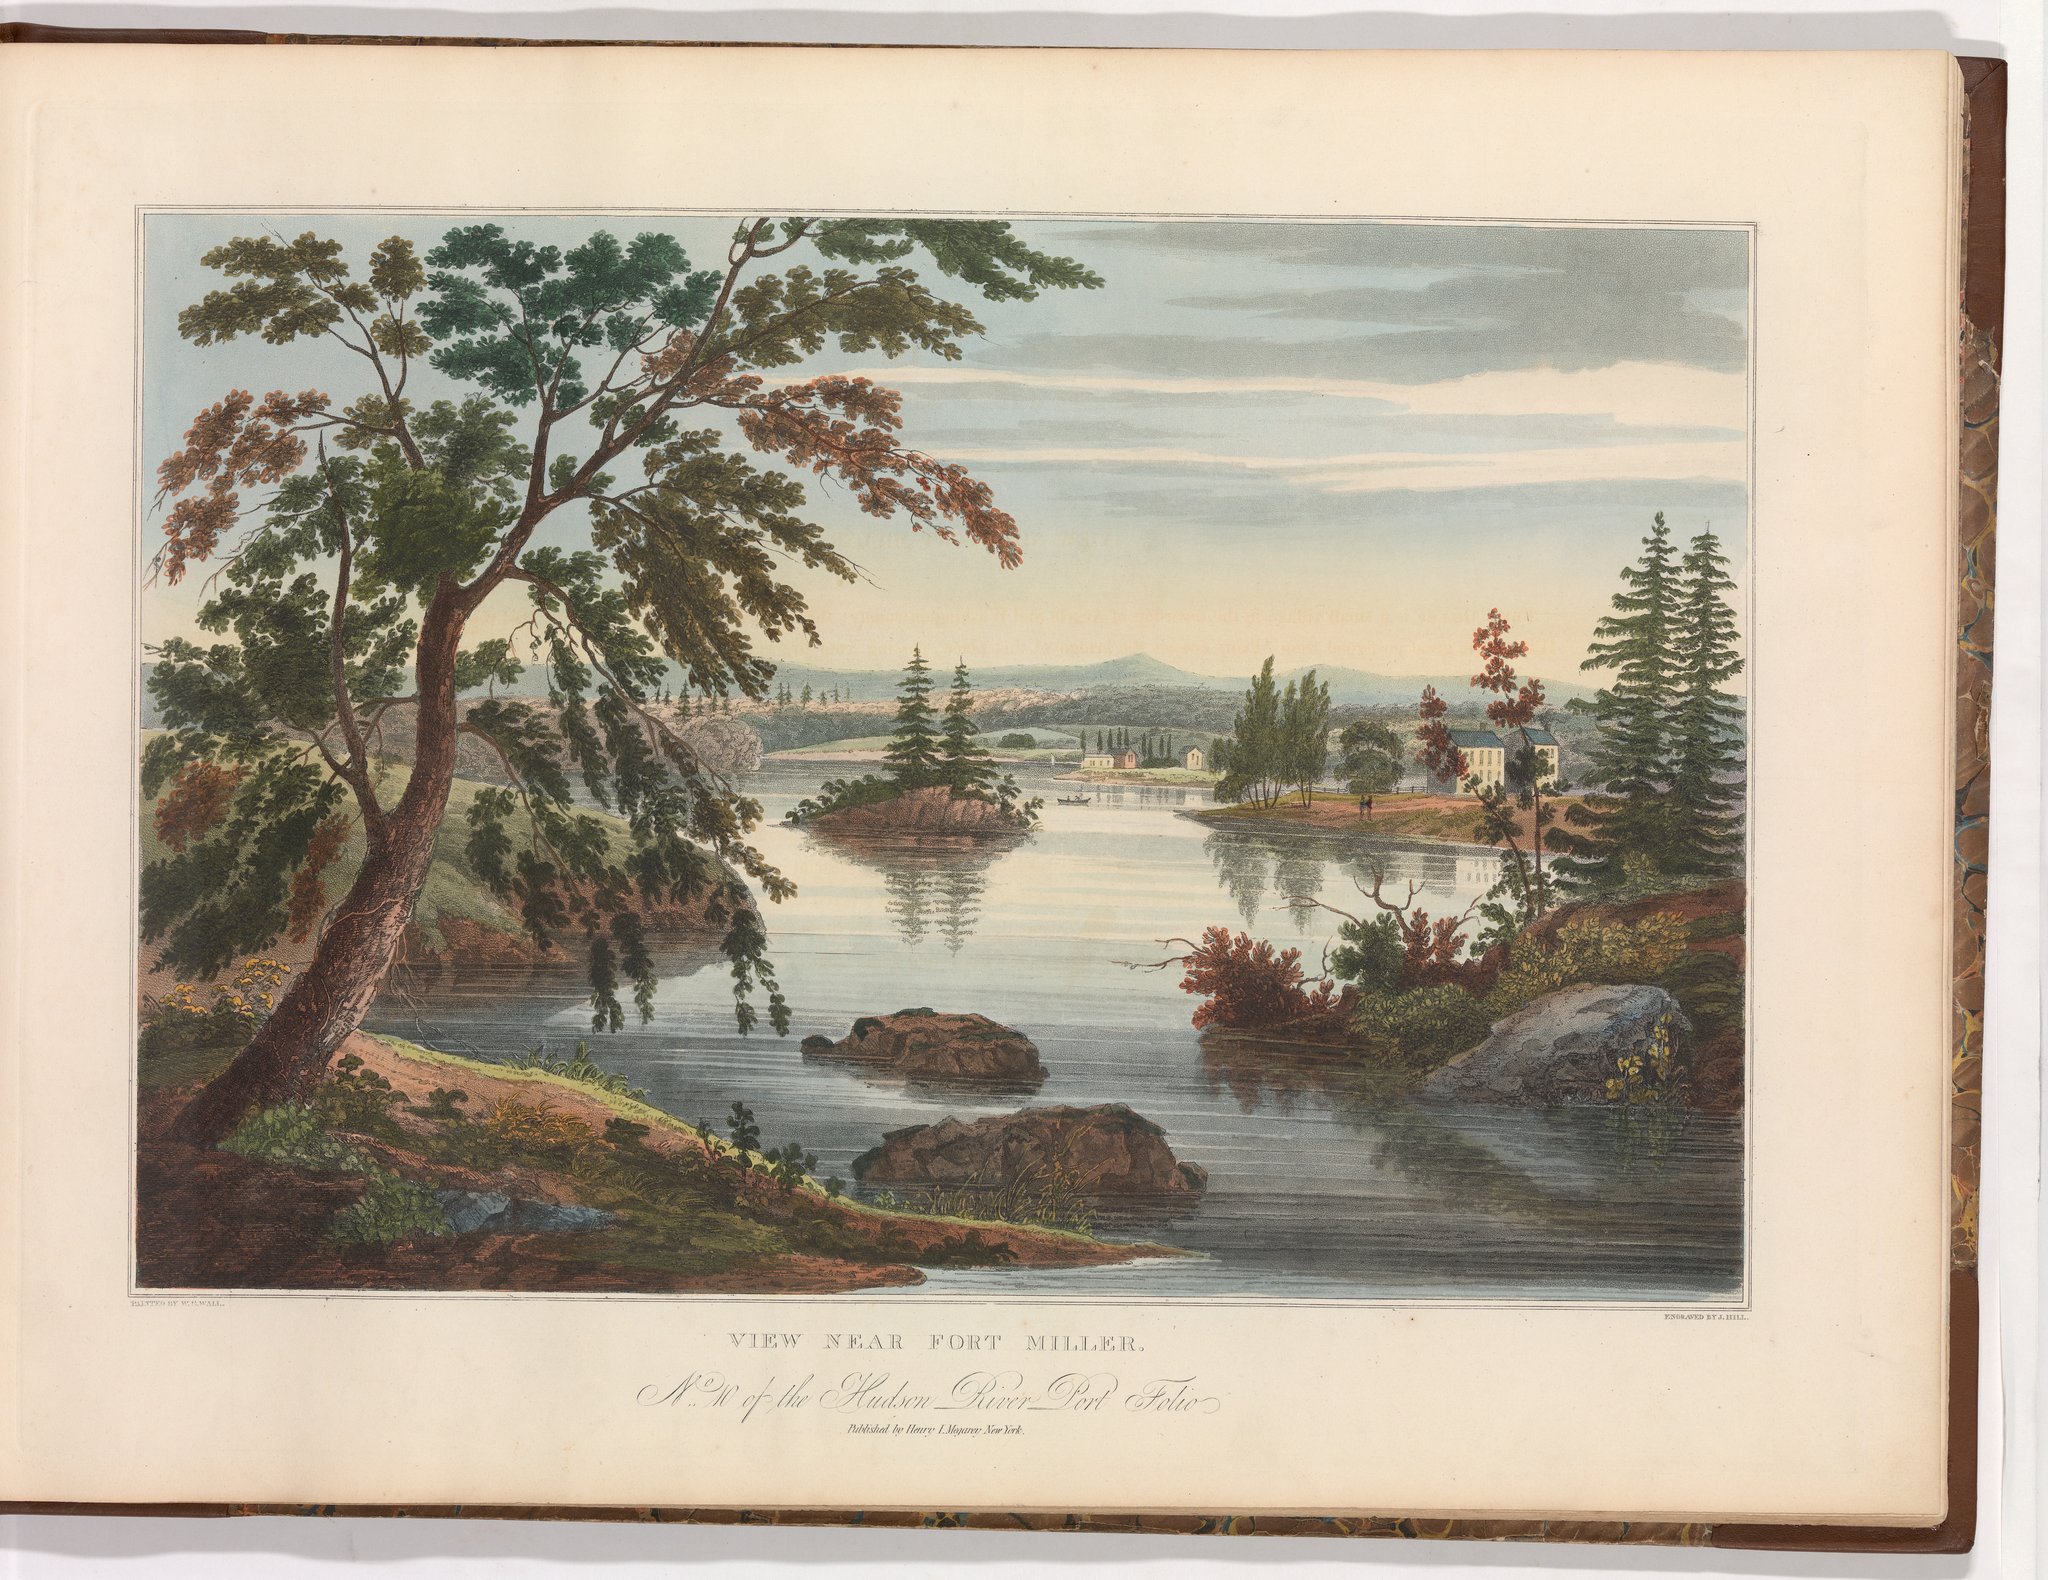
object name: print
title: View Near Fort Miller (No. 10 (later changed to No. 9) of The Hudson River Portfolio)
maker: john hill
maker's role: etcher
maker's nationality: american, born england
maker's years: 1770-1850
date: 1822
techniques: aquatint, hand coloring, printing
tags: rivers,landscapes,trees